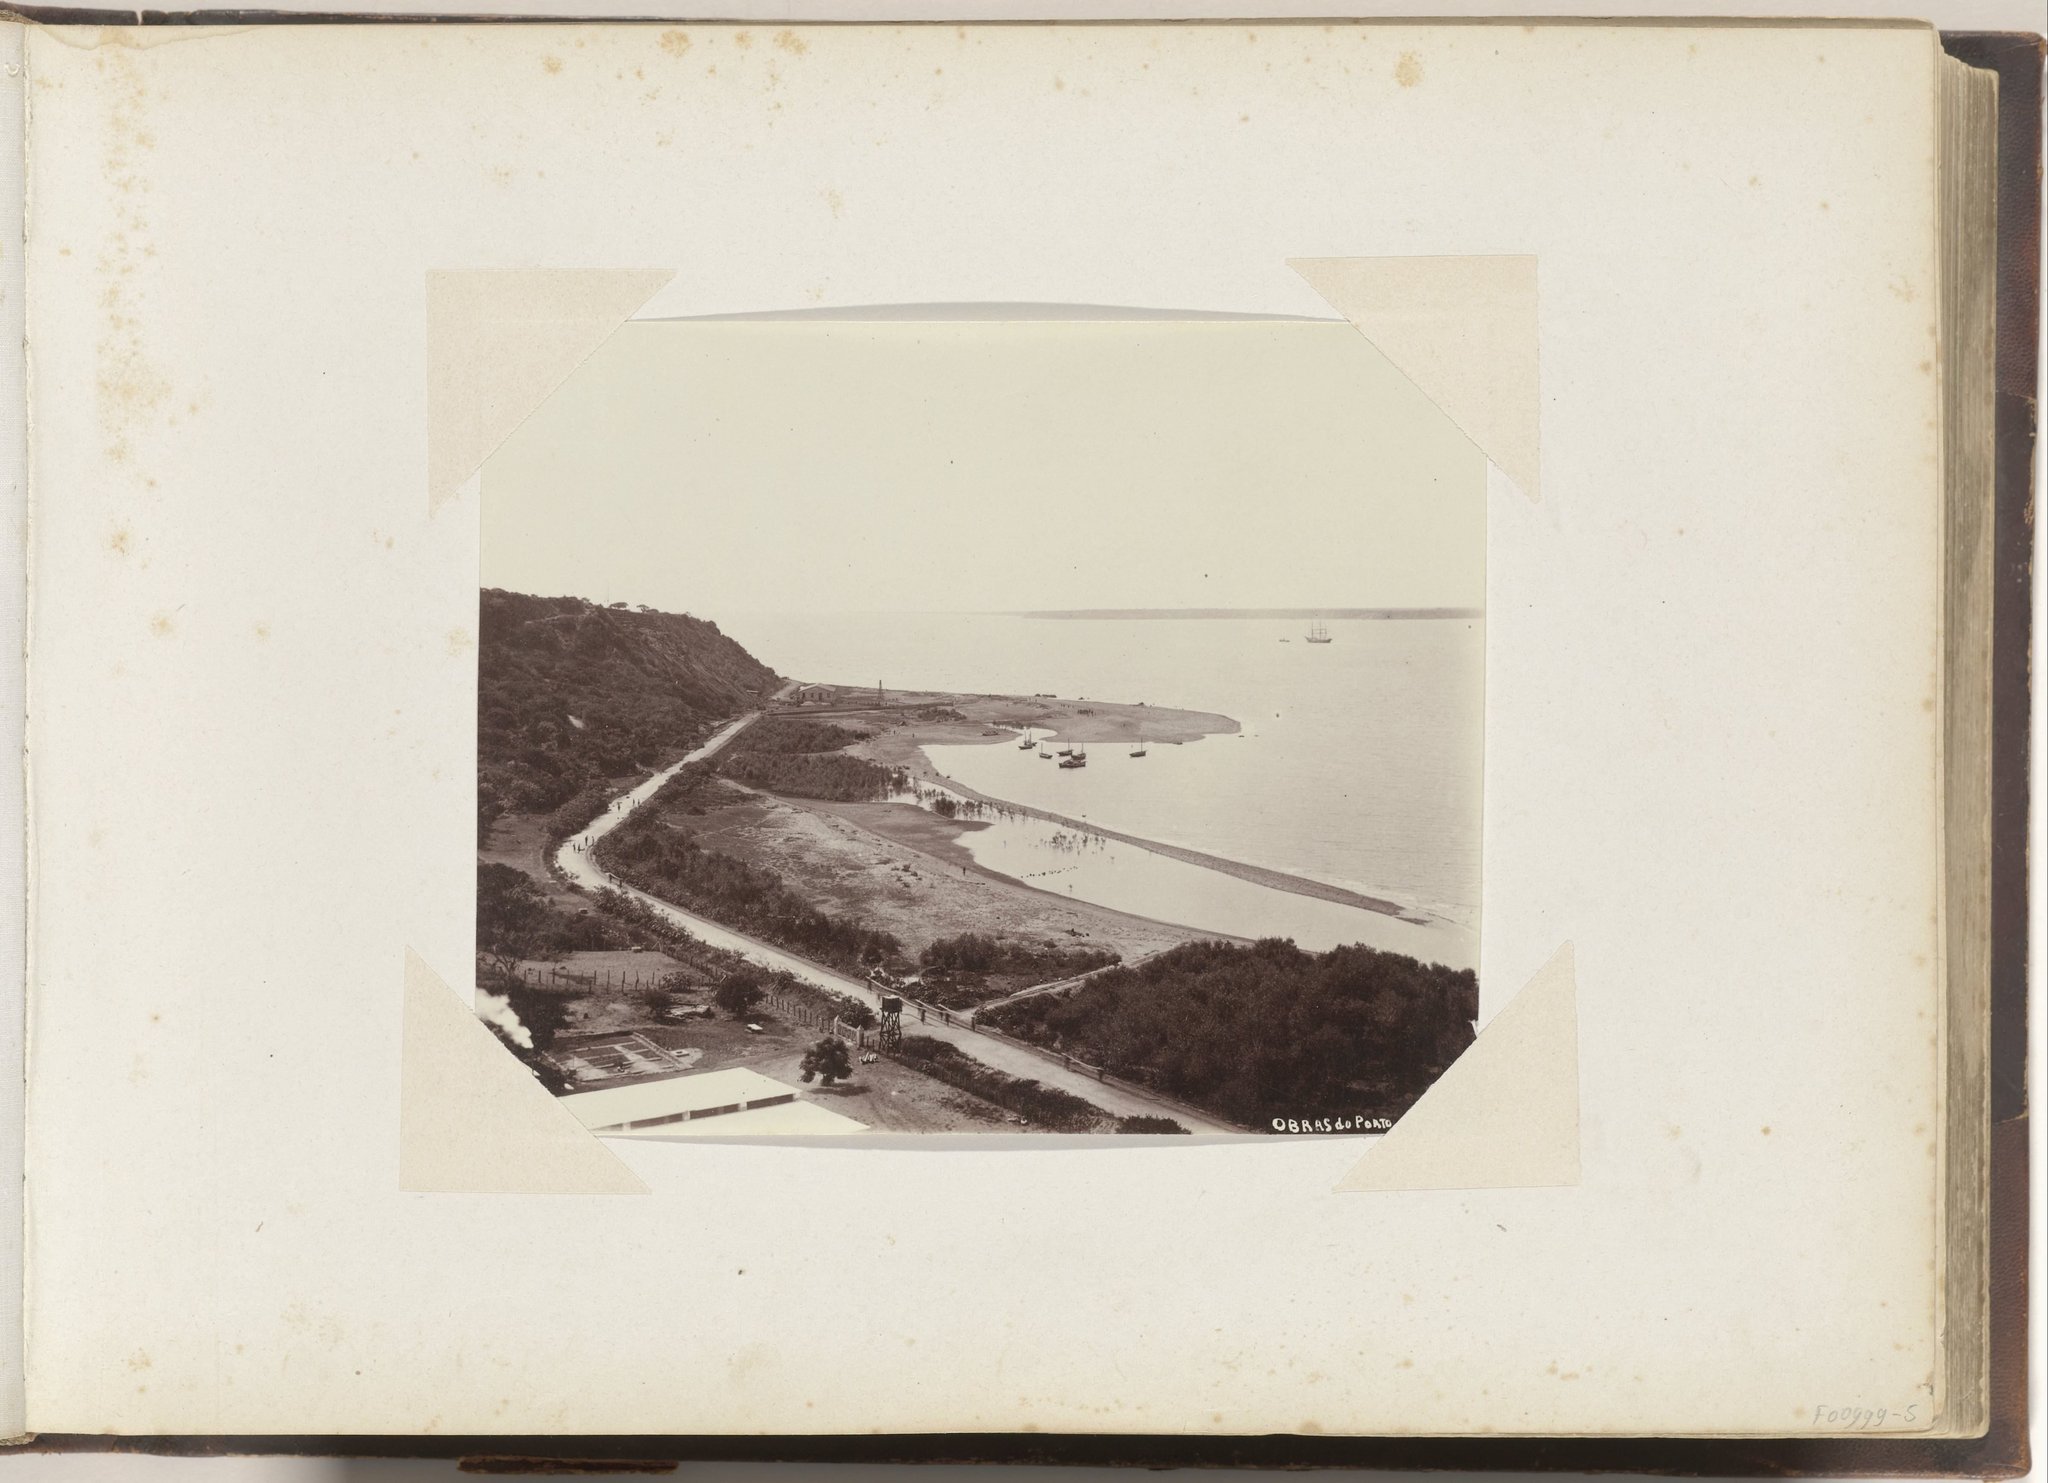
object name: photograph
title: Obras do Porto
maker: lm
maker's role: fotograaf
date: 1885-1910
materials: paper, photographic support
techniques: albumen print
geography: madeira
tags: harbour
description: Onderdeel van Album met 191 foto's van een reis naar en door Zuid-Afrika.